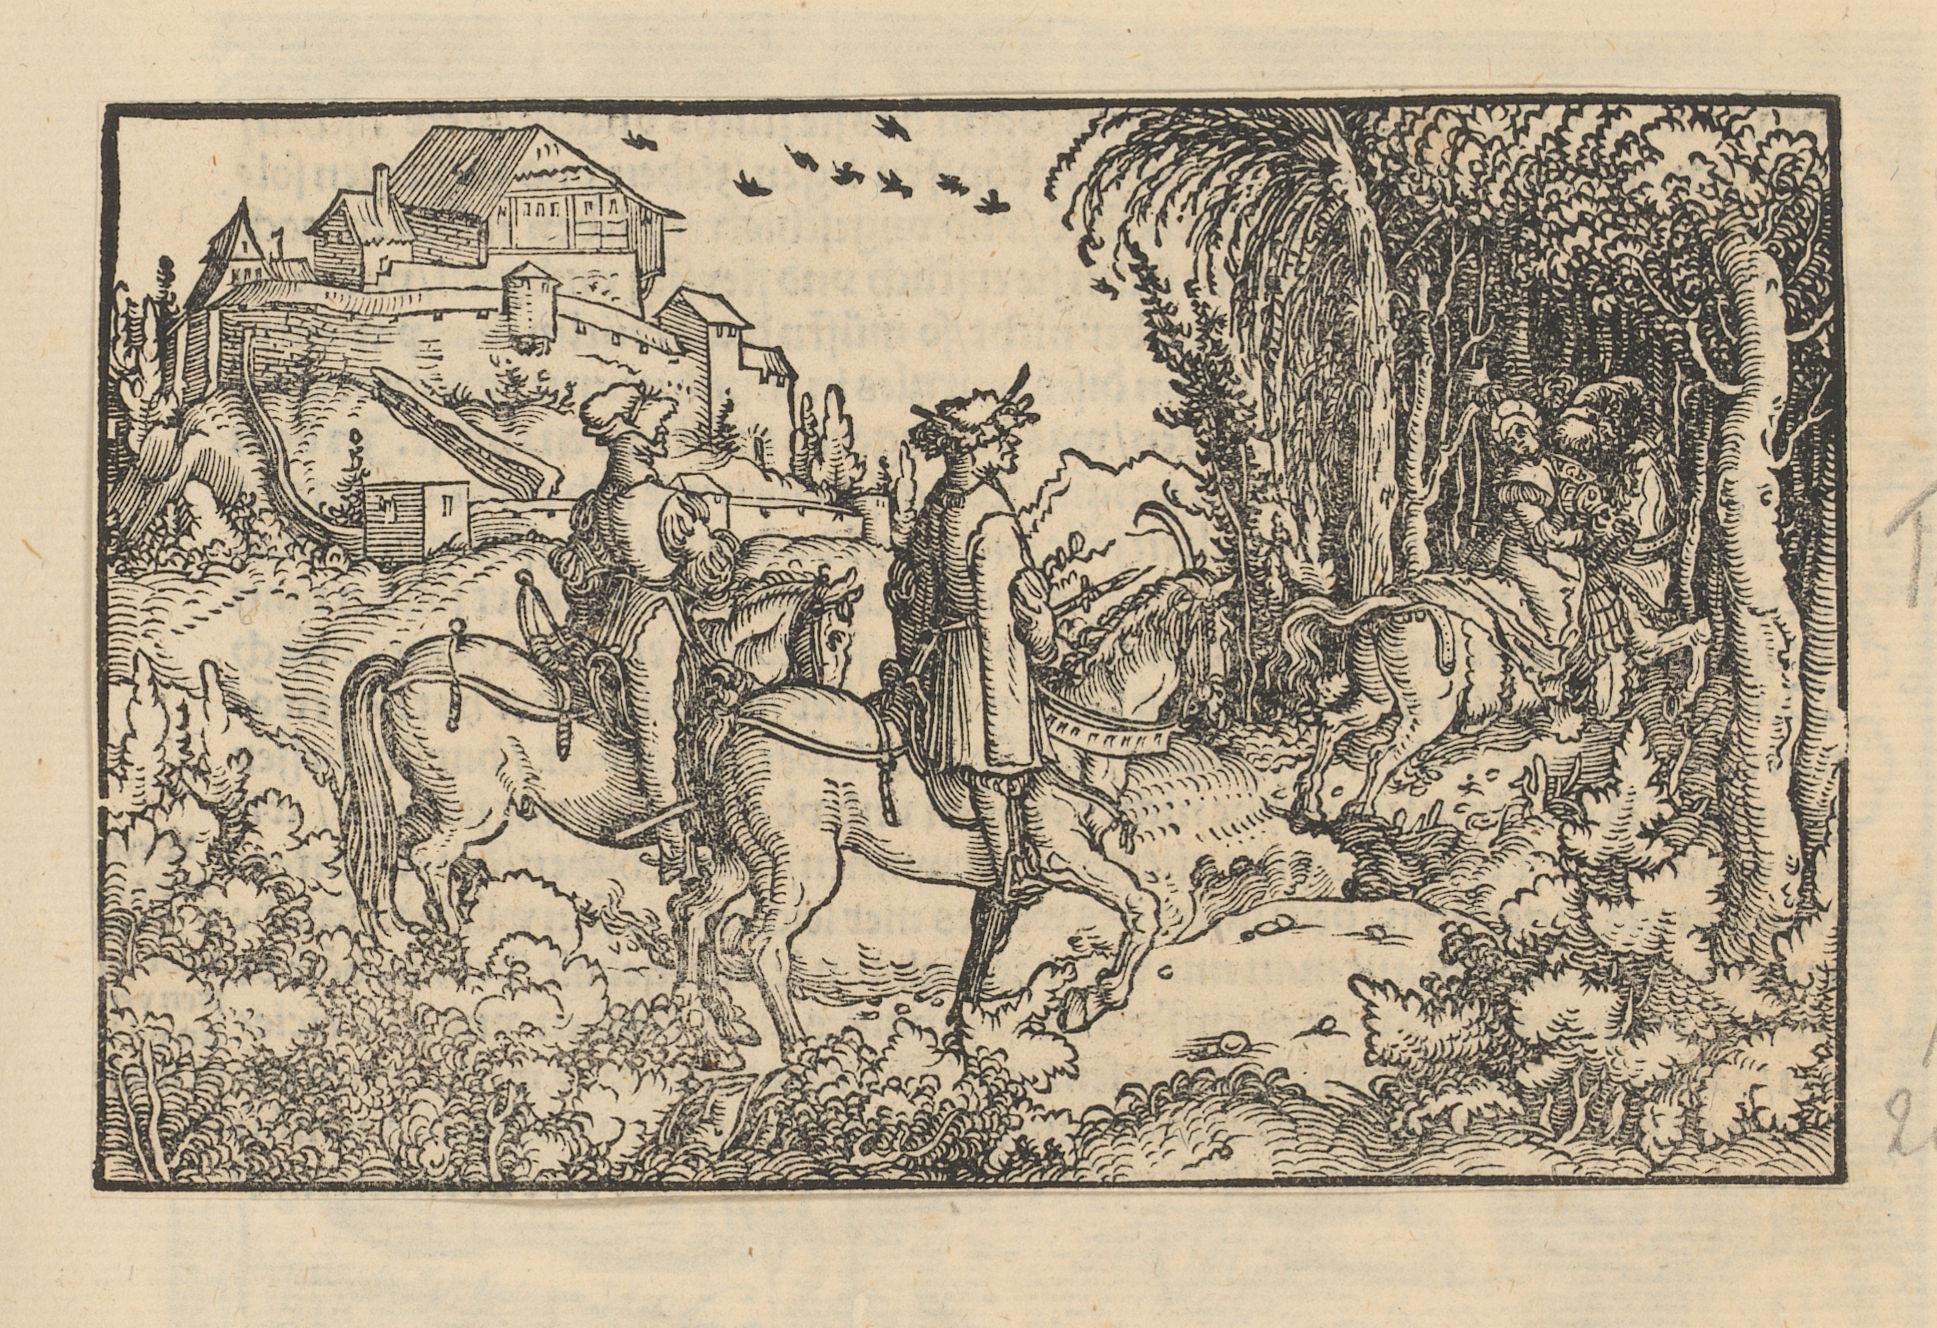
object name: book illustration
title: Twee ruiters kijken toe hoe een vrouw ontvoerd wordt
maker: Anonymous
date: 1514-1532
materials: paper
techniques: letterpress printing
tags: riding a horse, ass, or mule; rider, horseman, city-view in general; 'veduta', kidnapping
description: Deze prent is gebruikt in: Petrarca, Francesco. Von der Artzney bayder Glück, des guten und widerwertigen: unnd weß sich ain yeder inn Gelück und Unglück halten sol (...). Augsburg: Heinrich Steiner, 1532. Deze uitgave is ook bekend onder de titel 'Trostspiegel in Glück und Unglück'.